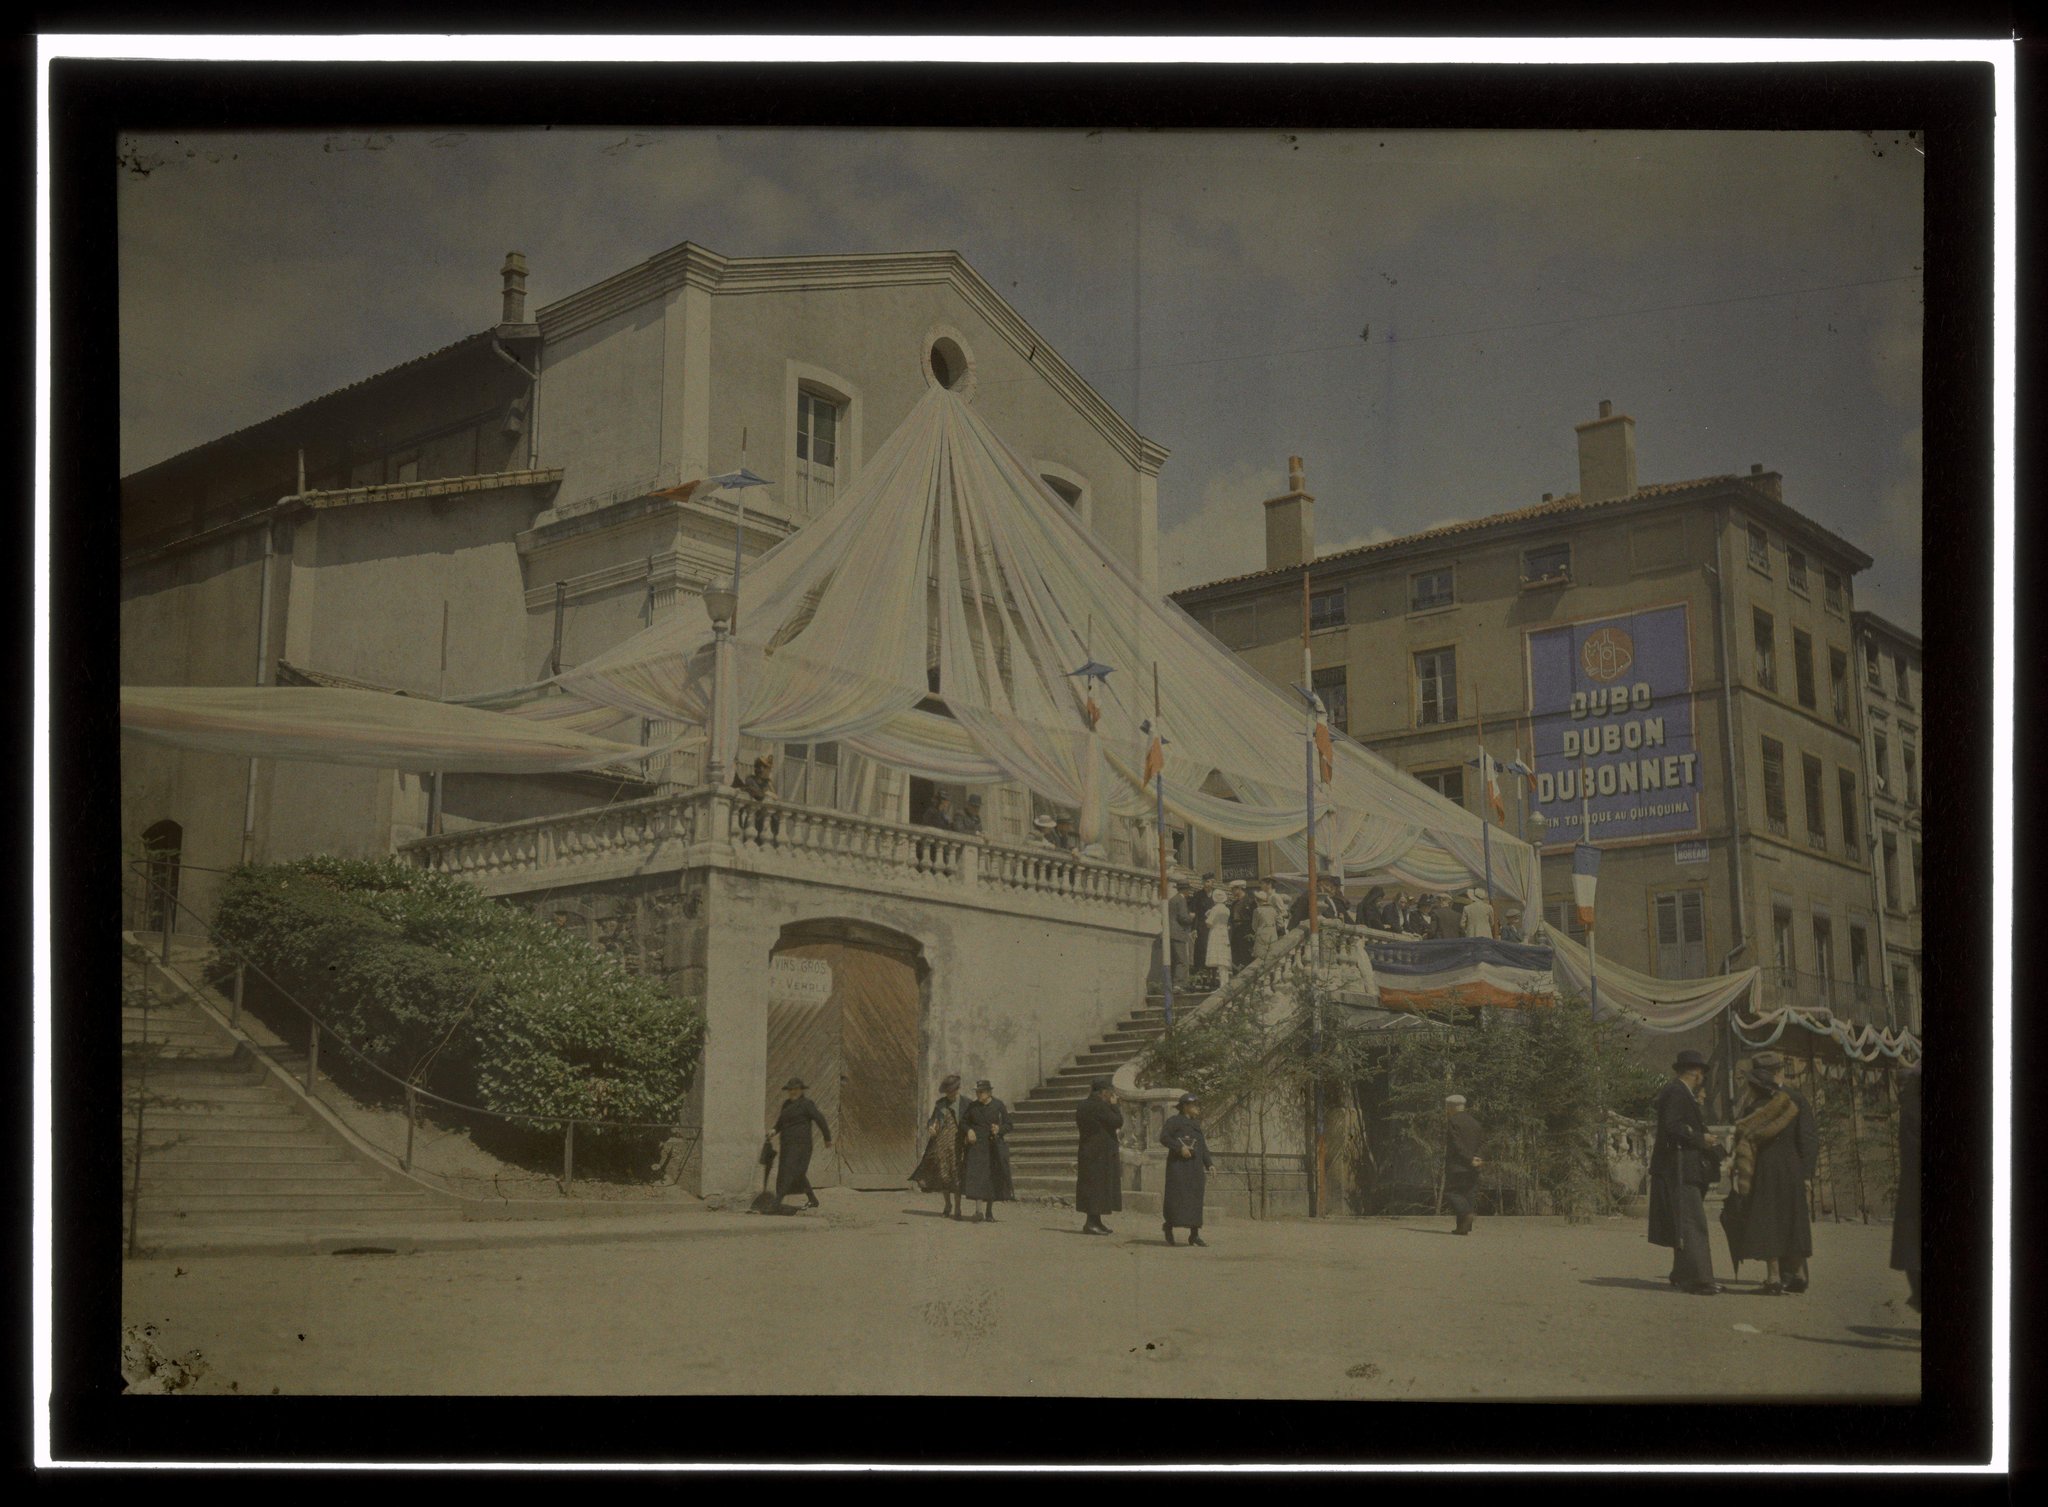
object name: photograph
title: Straatscène bij met vlaggen versierd stadhuis, met reclame voor Dubonnet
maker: Anonymous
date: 1935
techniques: autochrome process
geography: france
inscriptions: inscription: ‘G’